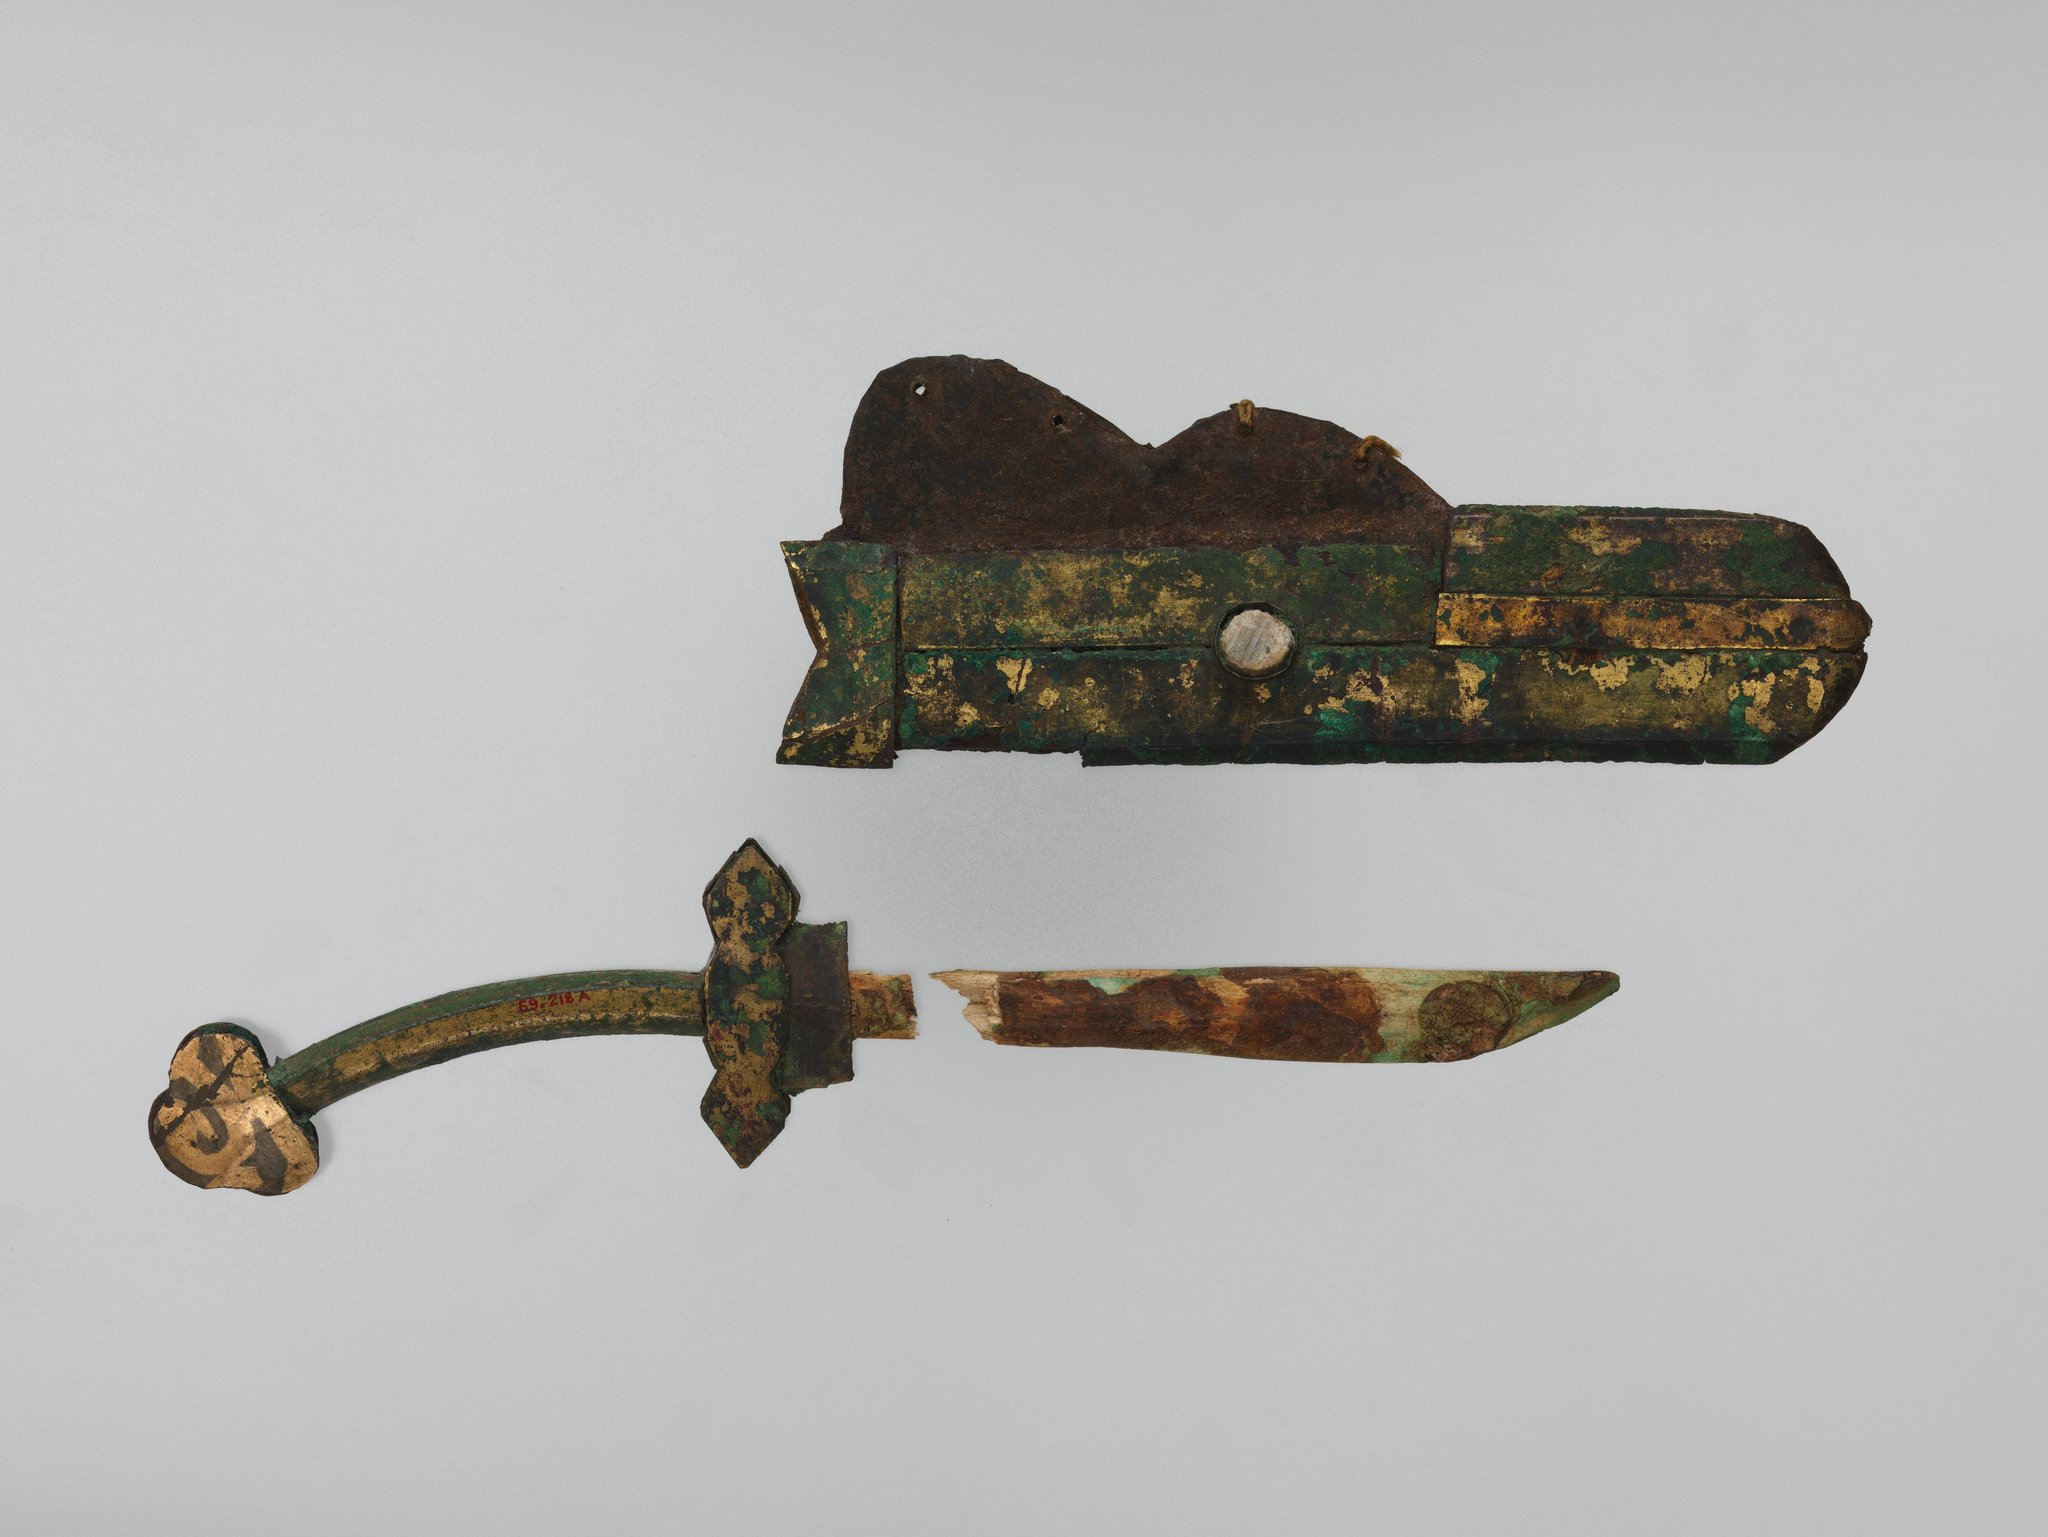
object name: dagger with sheath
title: Dagger and Sheath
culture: chinese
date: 300-201 BCE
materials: bronze, gold